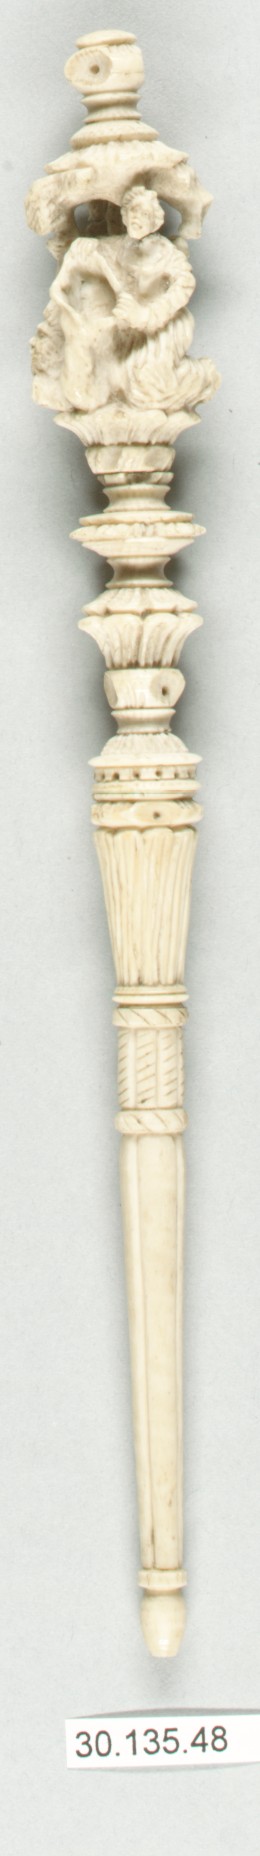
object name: needle sheath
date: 1601-1700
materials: bone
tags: human figures